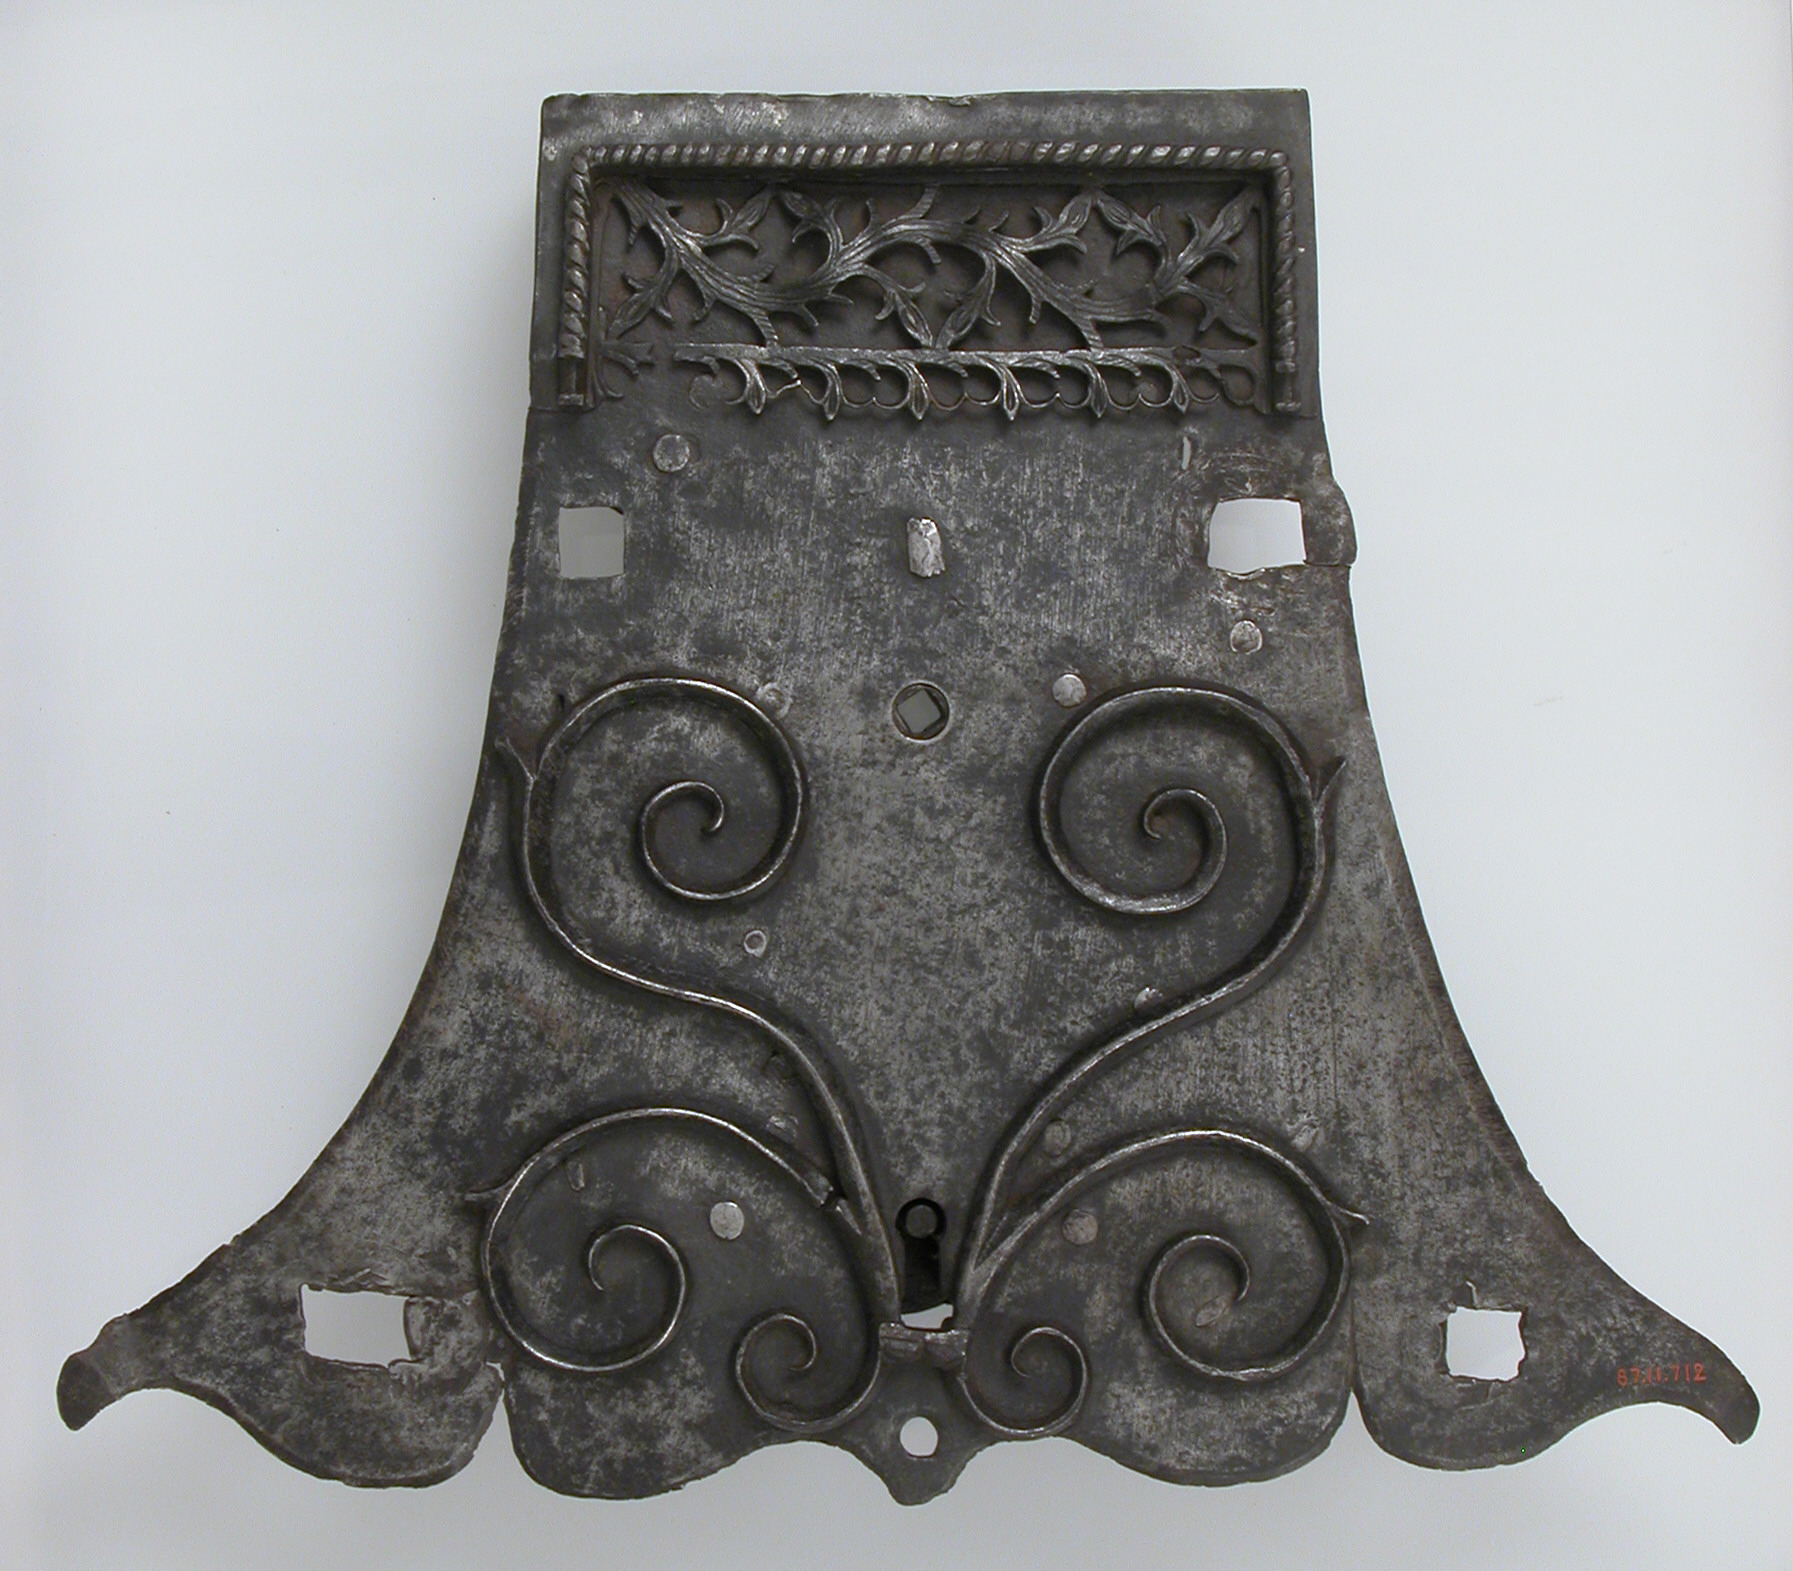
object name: mortise lock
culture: german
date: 1467-1500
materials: iron